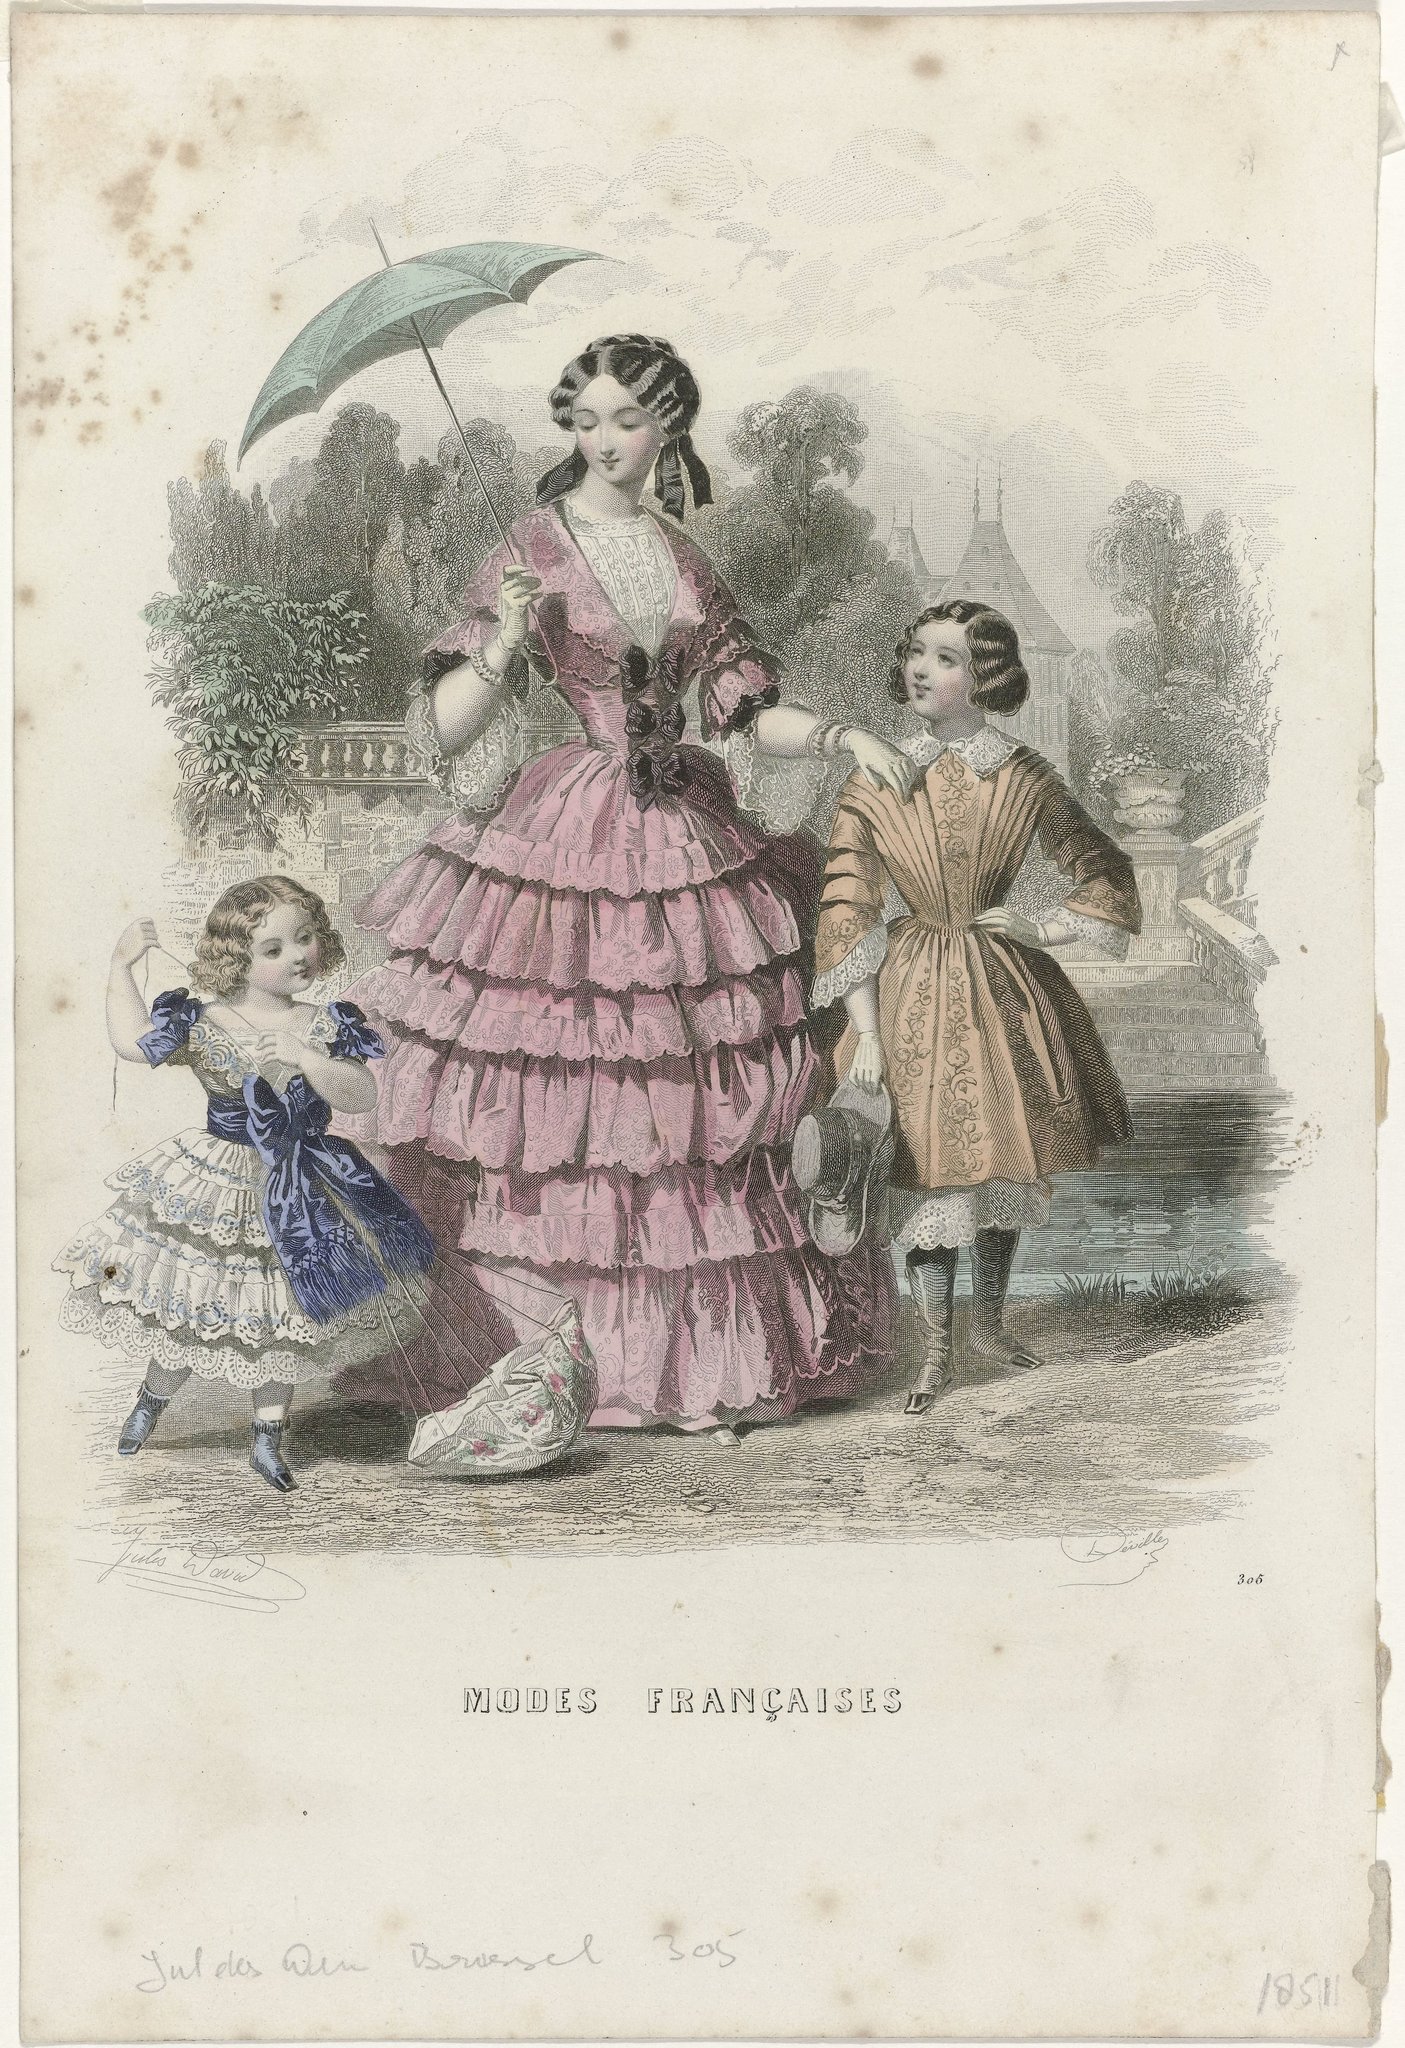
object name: fashion print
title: Journal des Demoiselles, 1851, No. 305: Modes Françaises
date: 1851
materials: paper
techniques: engraving, hand coloring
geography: paris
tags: bow (ornamental part of clothing) (+ women's clothes), clothes, costume (+ girls' clothes), (playing with) toys ~ air, sky diving, parachuting as a sport (+ variant), clothes, costume (+ boys' clothes), head-gear (+ women's clothes), fashion plates, gloves, mittens, etc. (+ women's clothes), neck-gear ~ clothing (+ women's clothes), parasol, sunshade (+ women's clothes)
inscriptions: caption: ‘Modes Françaises’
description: Een vrouw en twee kinderen in een park. Het kleine meisje speelt met een speelgoed parachute. De vrouw draagt een roze japon met v-hals en wijde strokenrok. Het lijfje en de halflange mouwen zijn versierd met strikken. Parasol in de hand. Prent uit het modetijdschrift Journal des Demoiselles (1833 -1922).